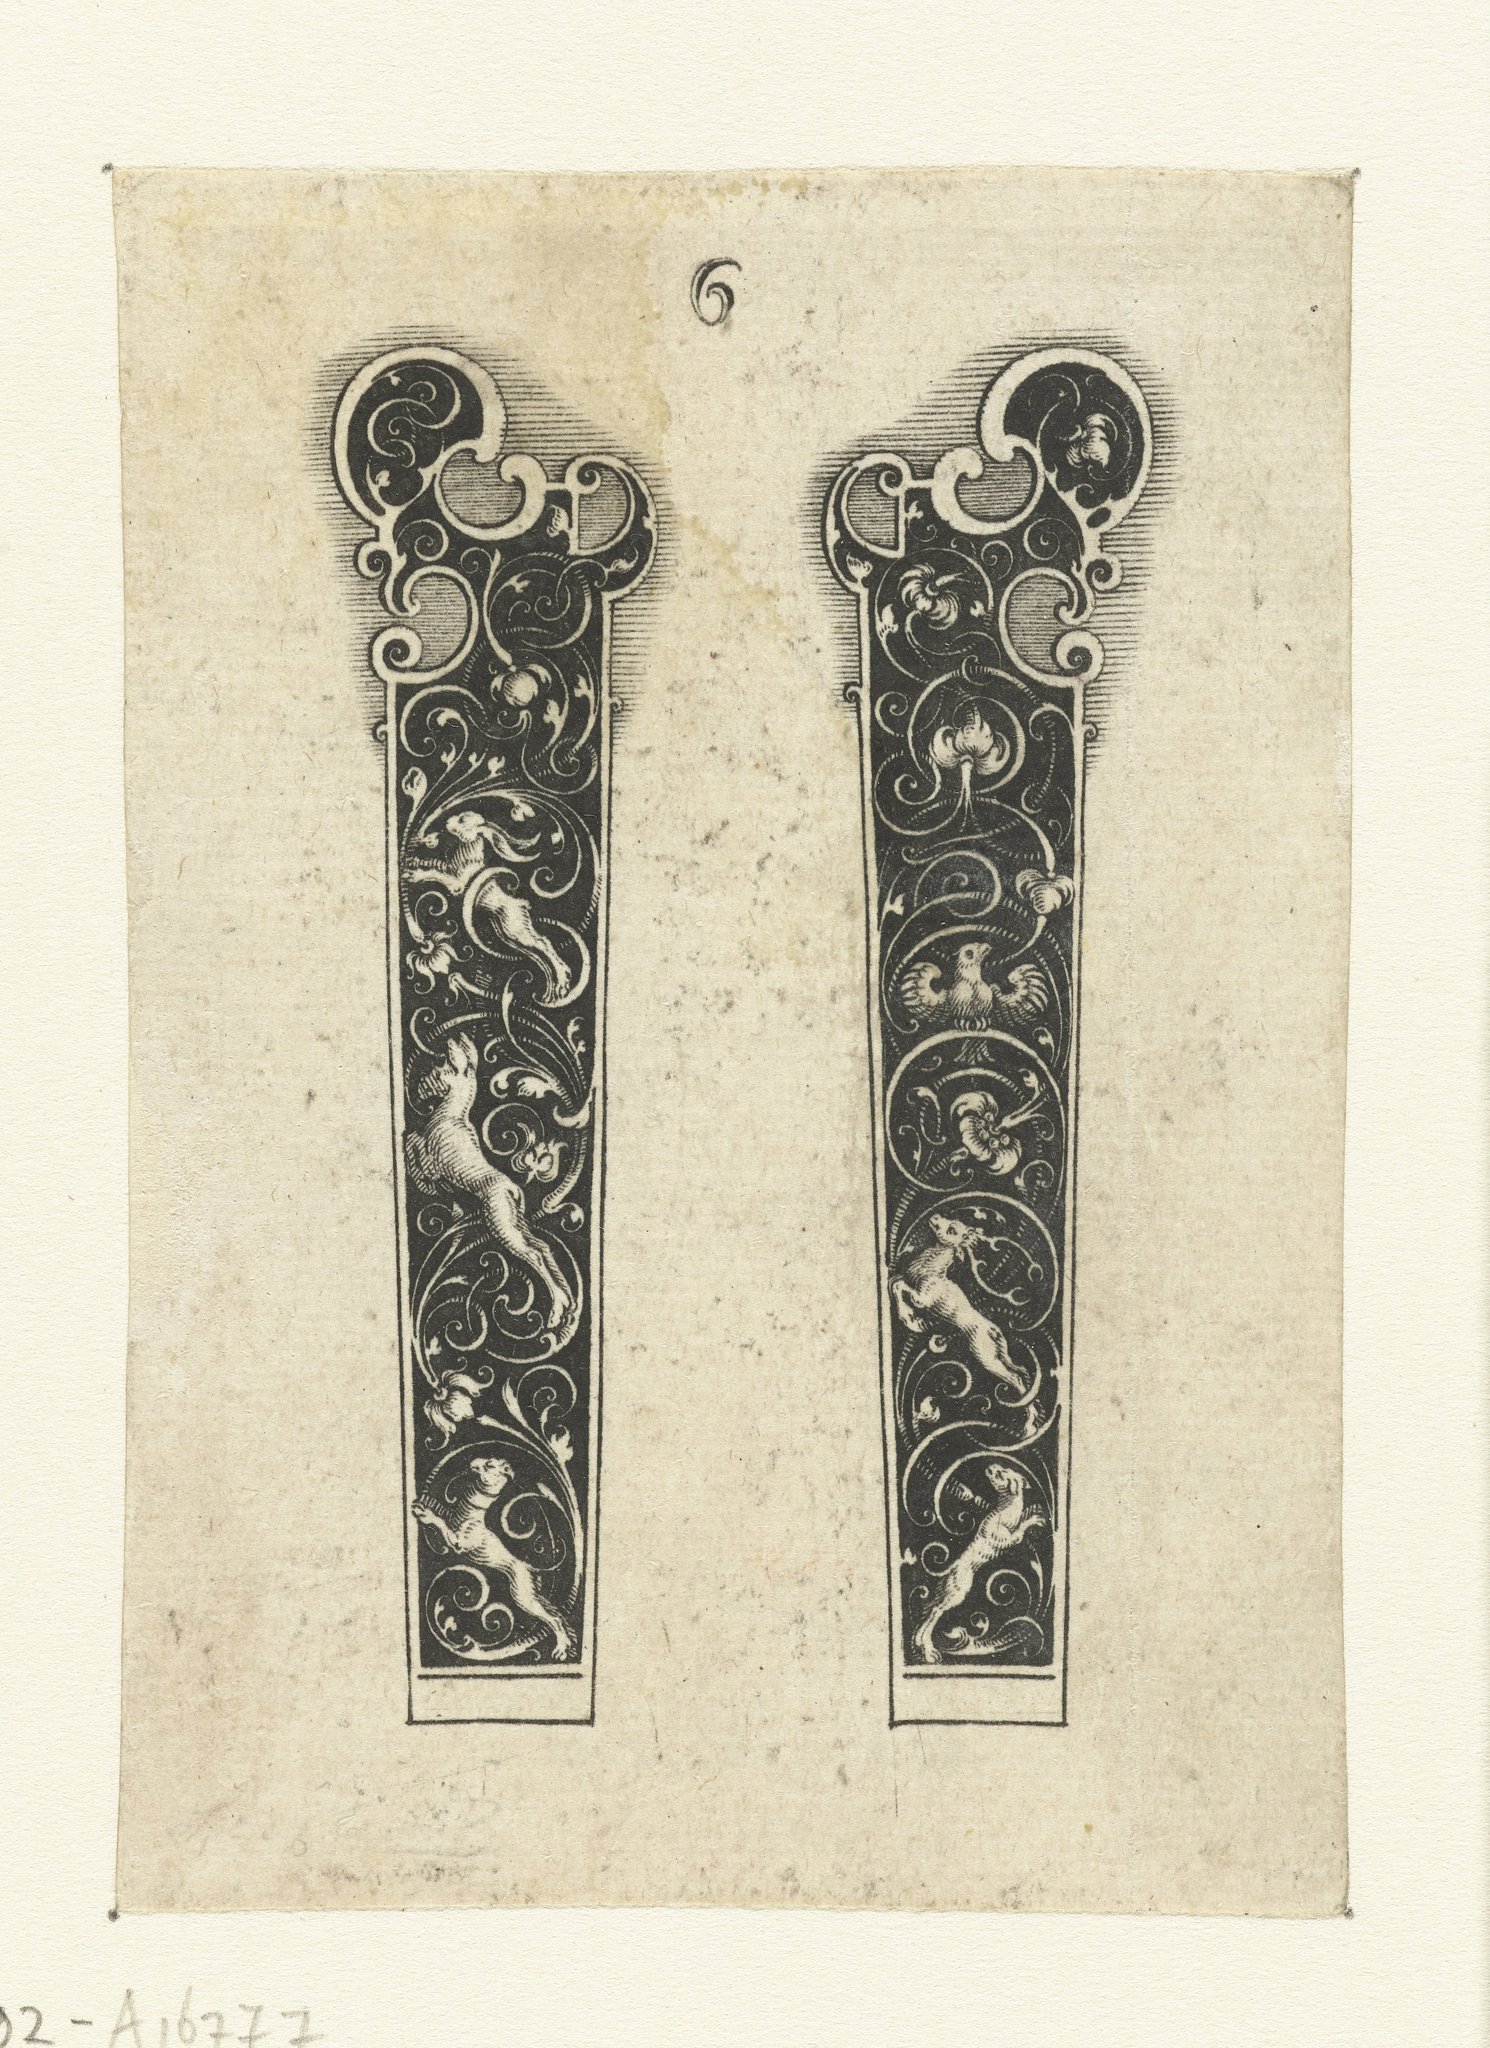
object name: ornament print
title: Twee messenheften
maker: michiel le blon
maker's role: print maker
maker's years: 1587-1656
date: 1597-1626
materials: paper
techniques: etching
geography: amsterdam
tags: table-knife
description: In het linkerheft bevinden zich een hond, een ree en een haas, in het rechterheft achtervolgt een hond een hert en een vogel.